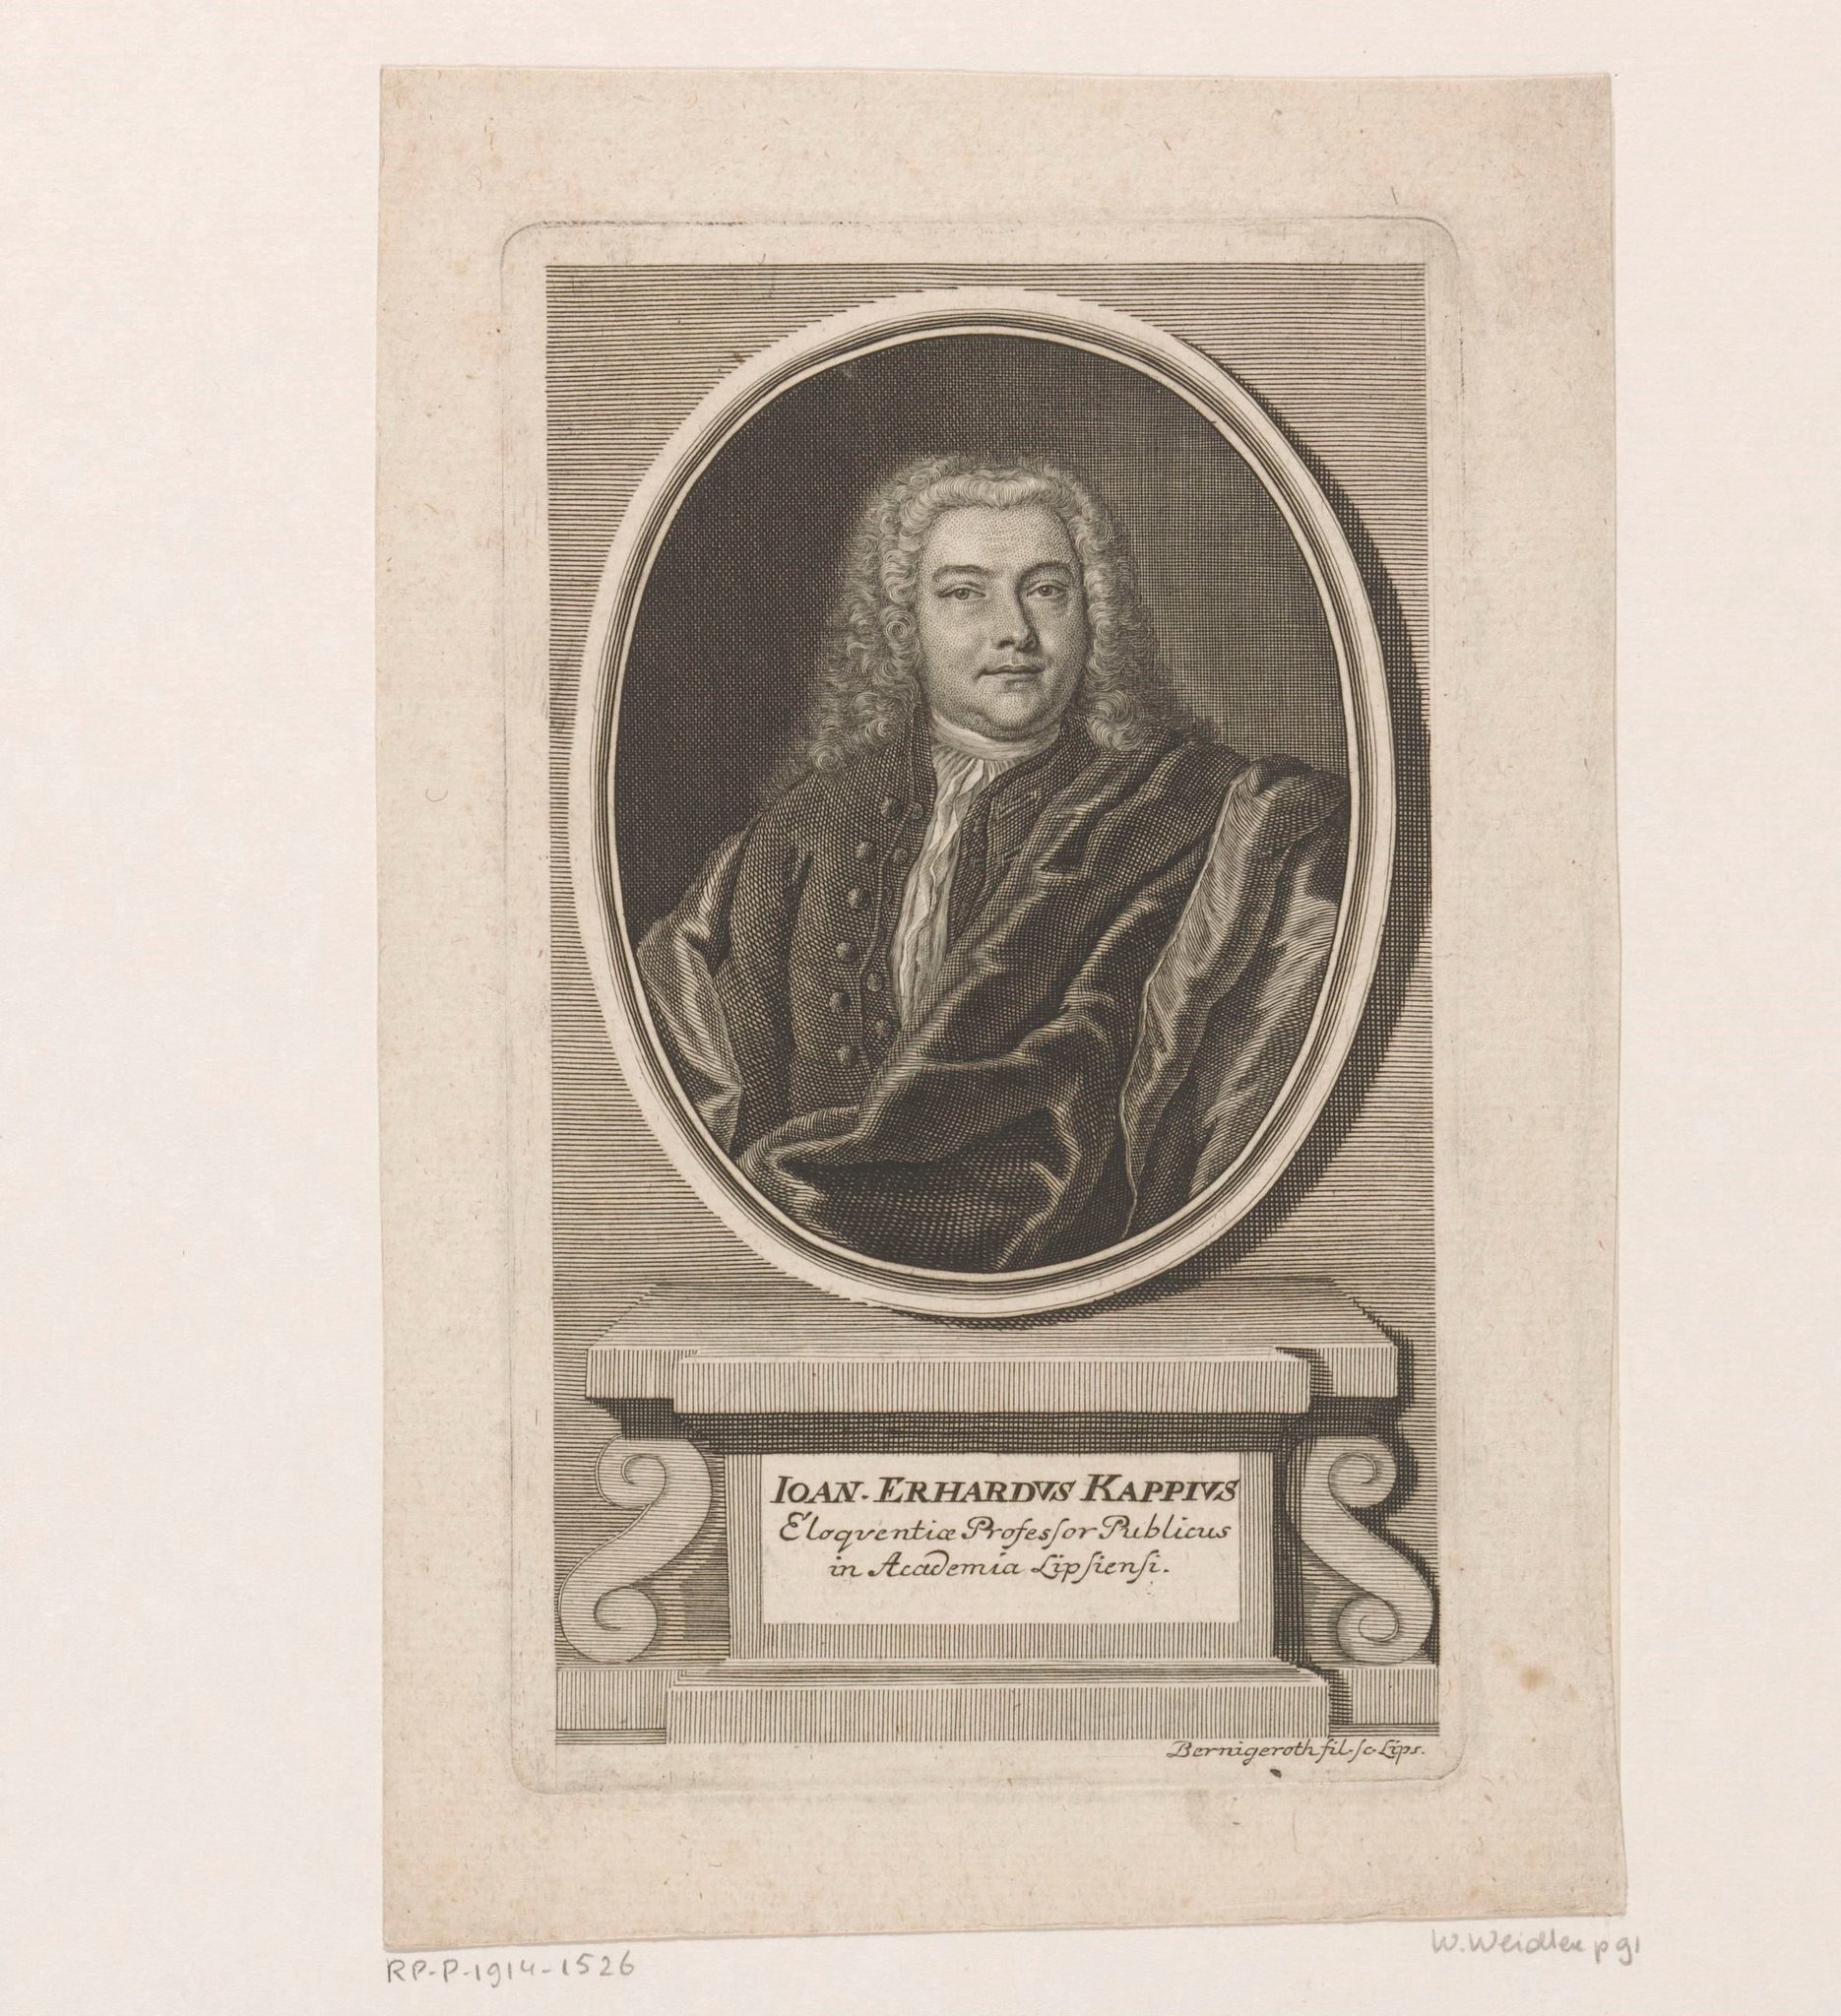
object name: print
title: Portret van Johann Erhard Kapp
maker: johann martin bernigeroth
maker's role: print maker, publisher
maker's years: 1713-1767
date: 1735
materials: paper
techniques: engraving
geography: leipzig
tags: historical persons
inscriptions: collector's mark: Lugt 2228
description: Prent ook gebruikt in: Deutsche Acta Eruditorum (...). dl. 195. Leipzig: Johann Gottlieb Gleditsch, 1735.